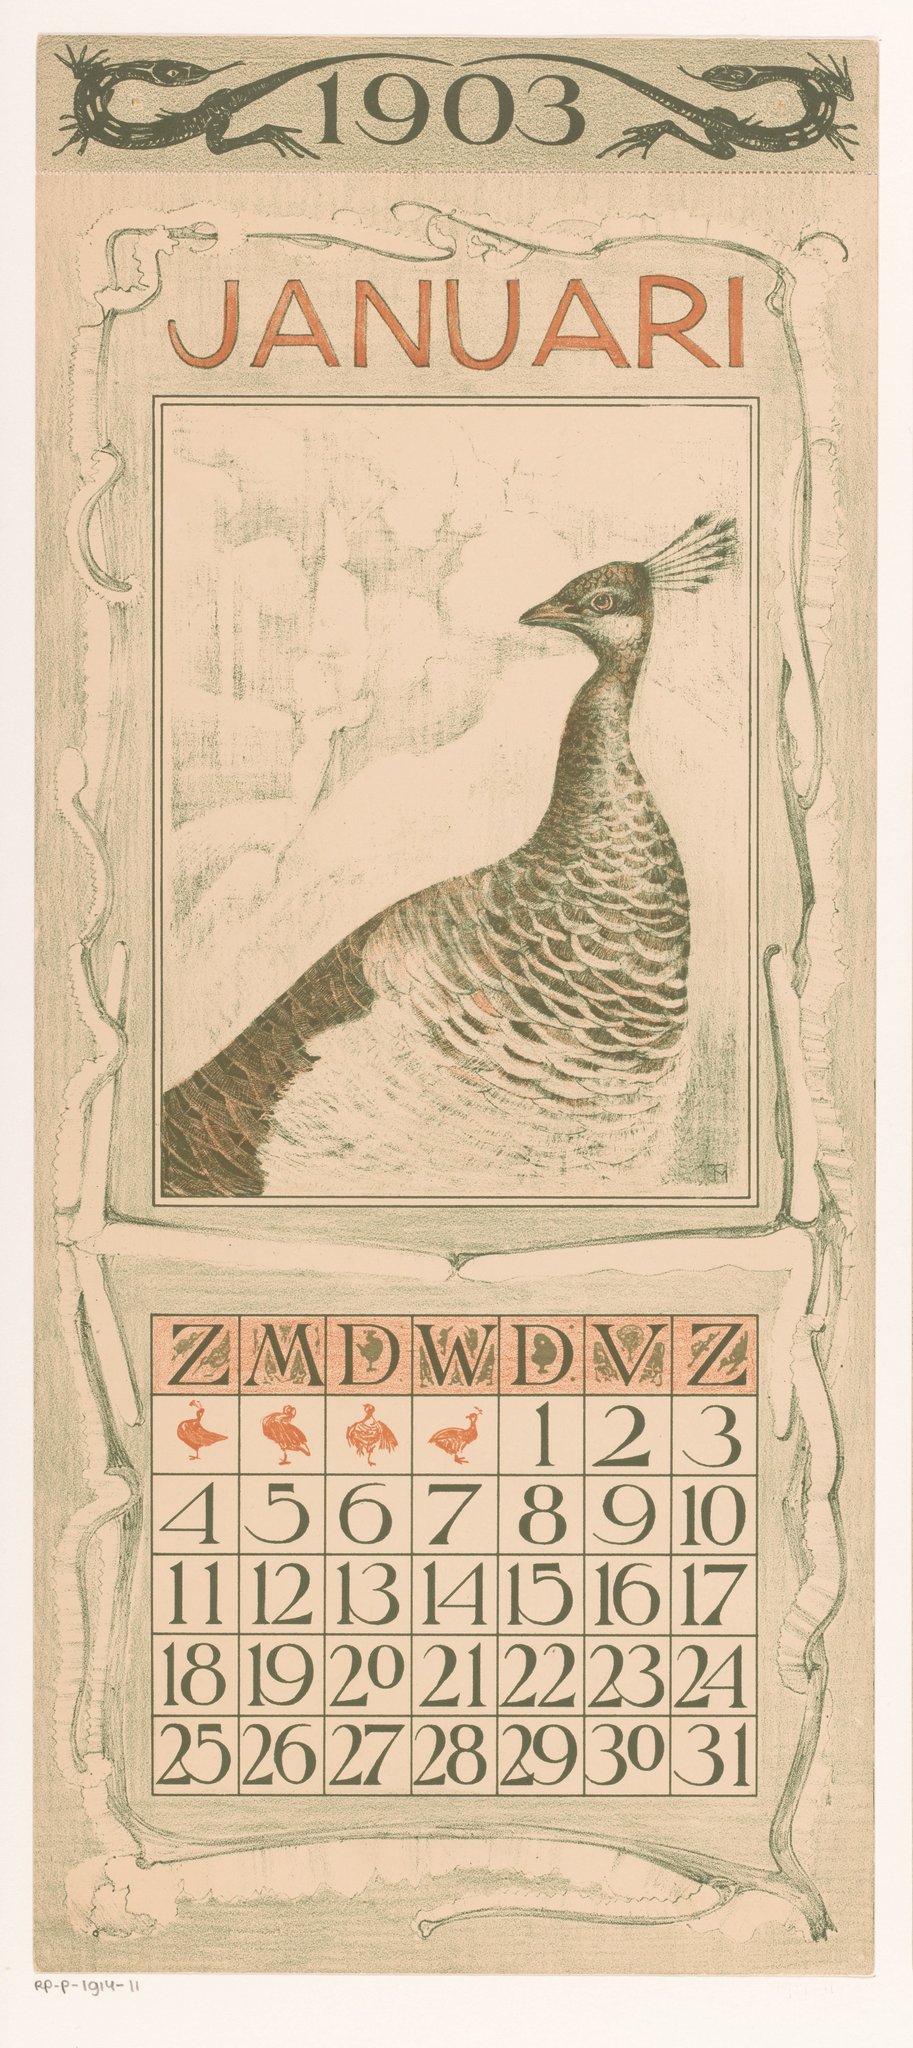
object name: print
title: Kalender 1903 12 lithografien door Th. v. Hoytema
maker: theo van hoytema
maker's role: draughtsman, painter, print maker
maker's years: 1863-1917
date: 1902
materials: paper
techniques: lithograph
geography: hilversum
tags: ornamental birds: peacock, january ~ other concepts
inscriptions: collector's mark: Lugt 2228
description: Bovenin twee reptielen. Onder het jaartal een scheurlijn.